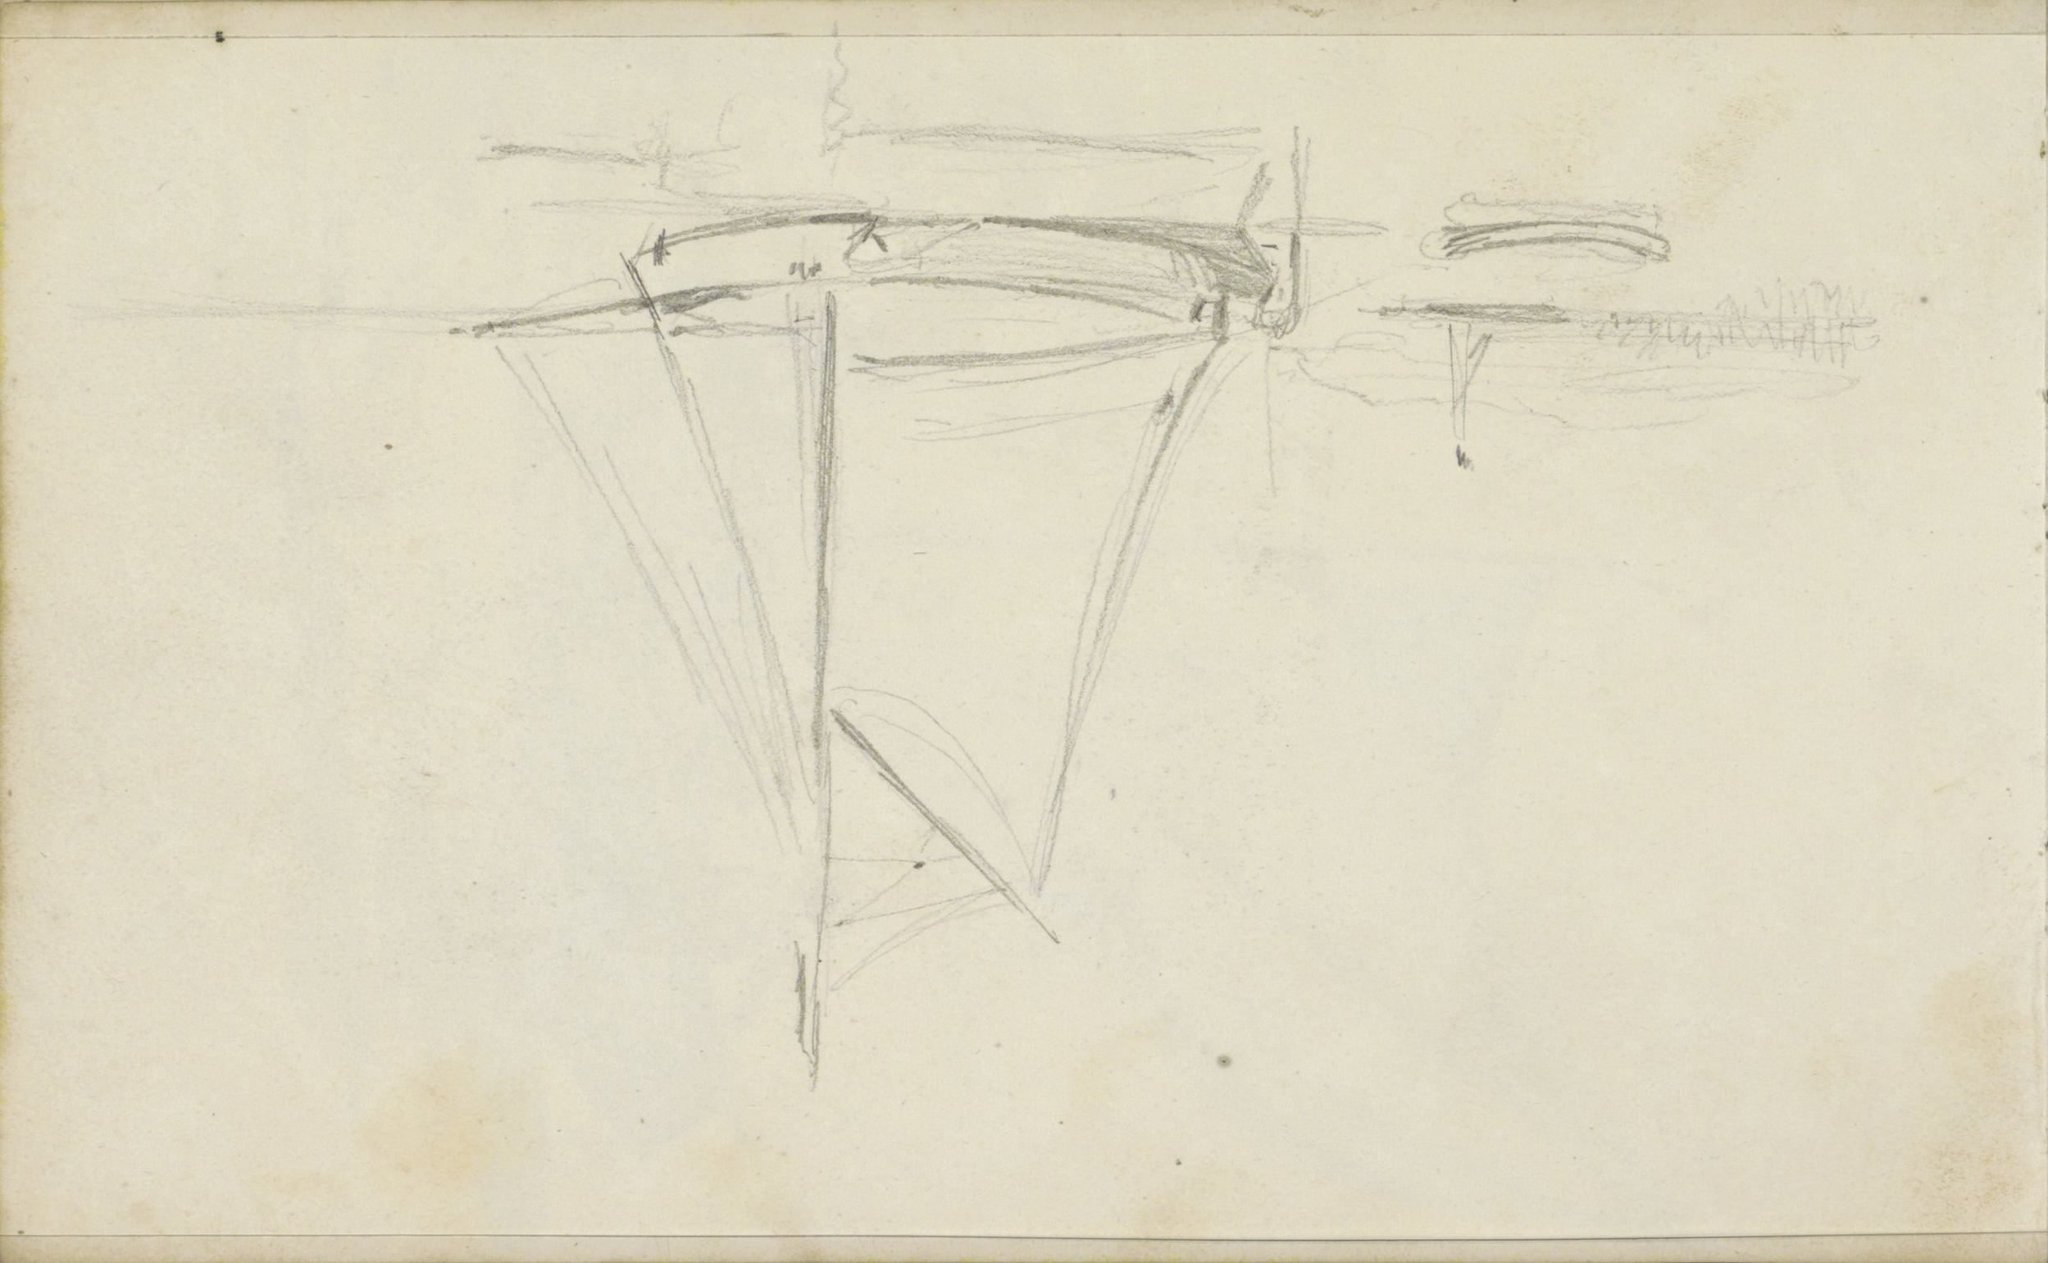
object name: sketchbook leaf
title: Twee zeilschepen en een roeiboot op open water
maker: adrianus eversen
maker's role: draughtsman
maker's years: 1818-1897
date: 1828-1897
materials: paper, pencil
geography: netherlands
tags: sailing-ship, sailing-boat, river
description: Twee zeilschepen op open water. Bij de voorste zeilschip ligt een roeiboot. Blad 26 verso uit een schetsboek met 27 bladen.